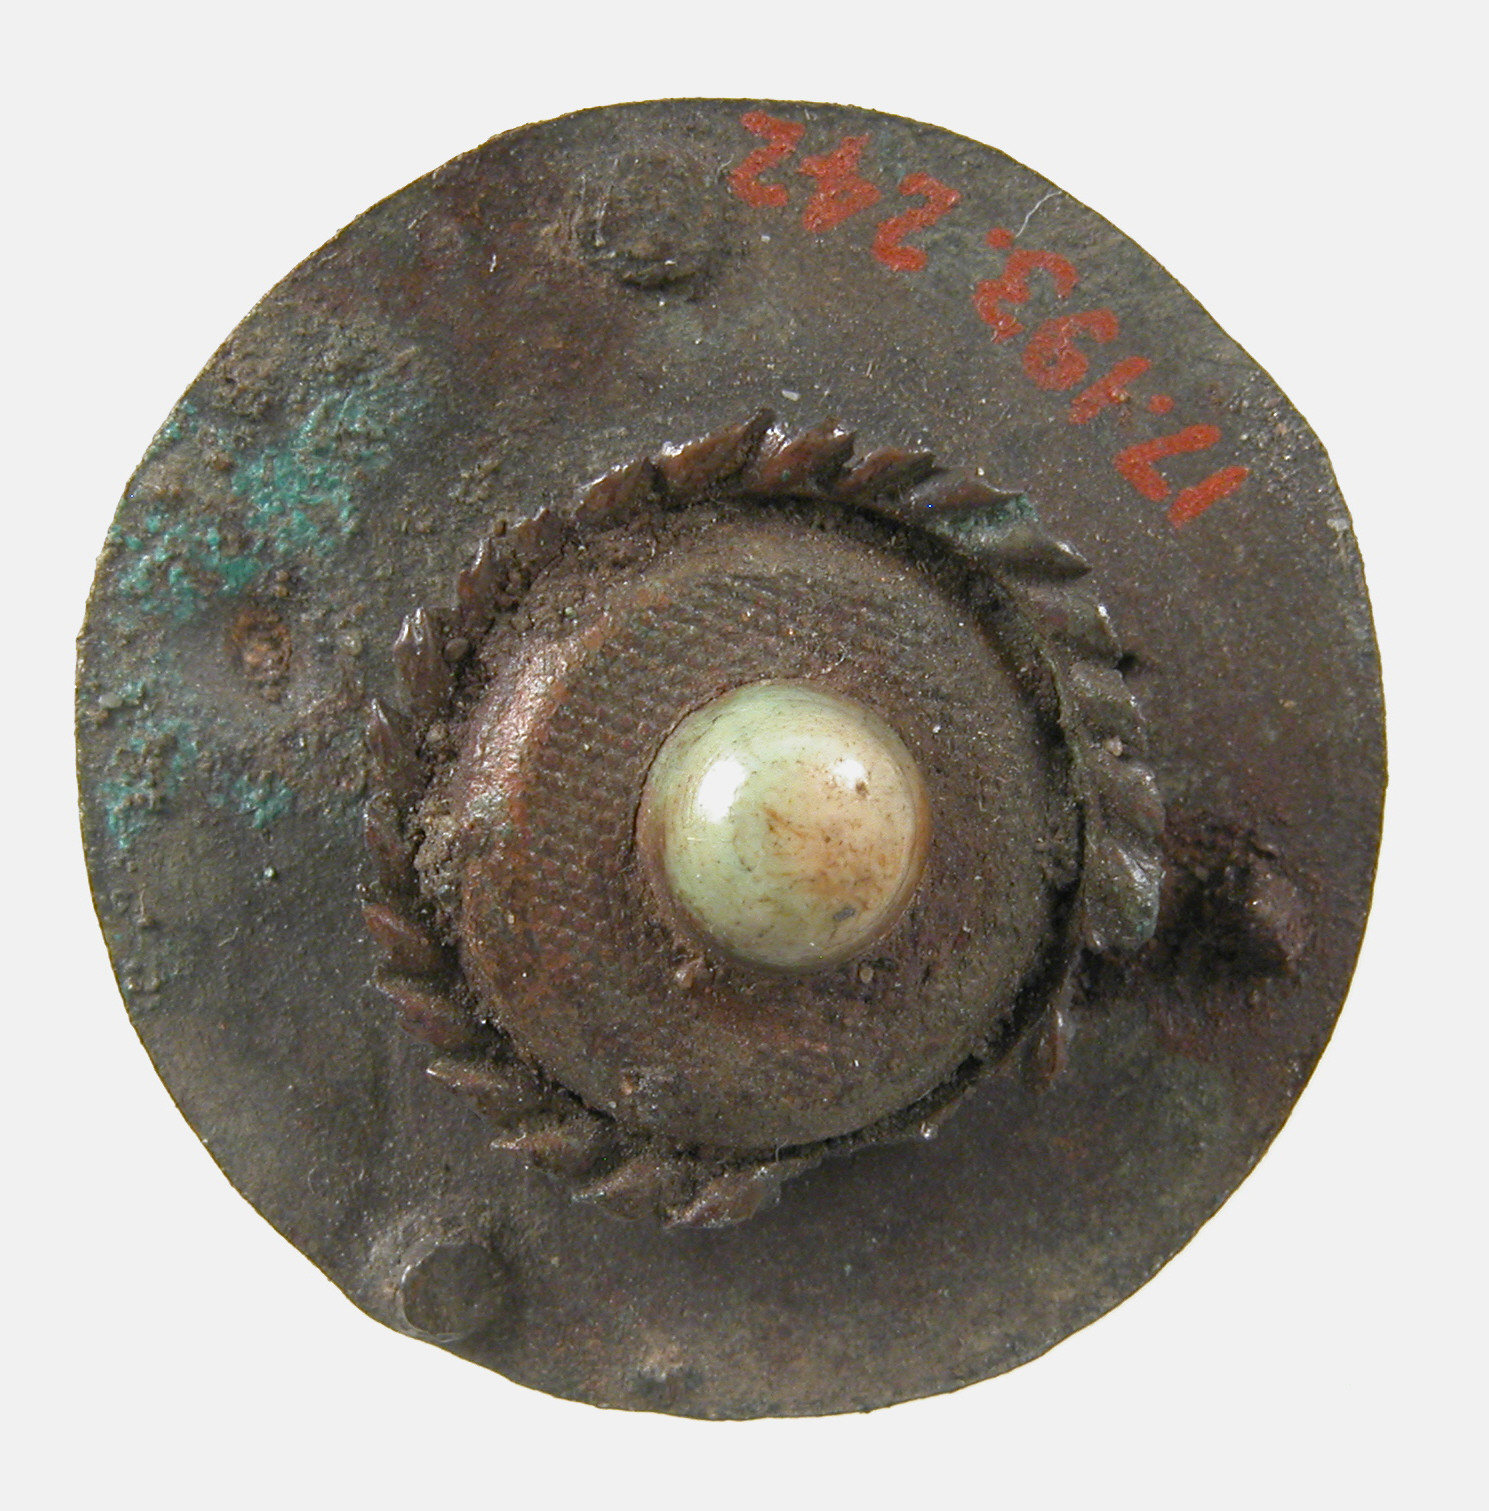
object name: disk brooch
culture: carolingian or frankish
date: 601-700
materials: copper alloy, glass, paste